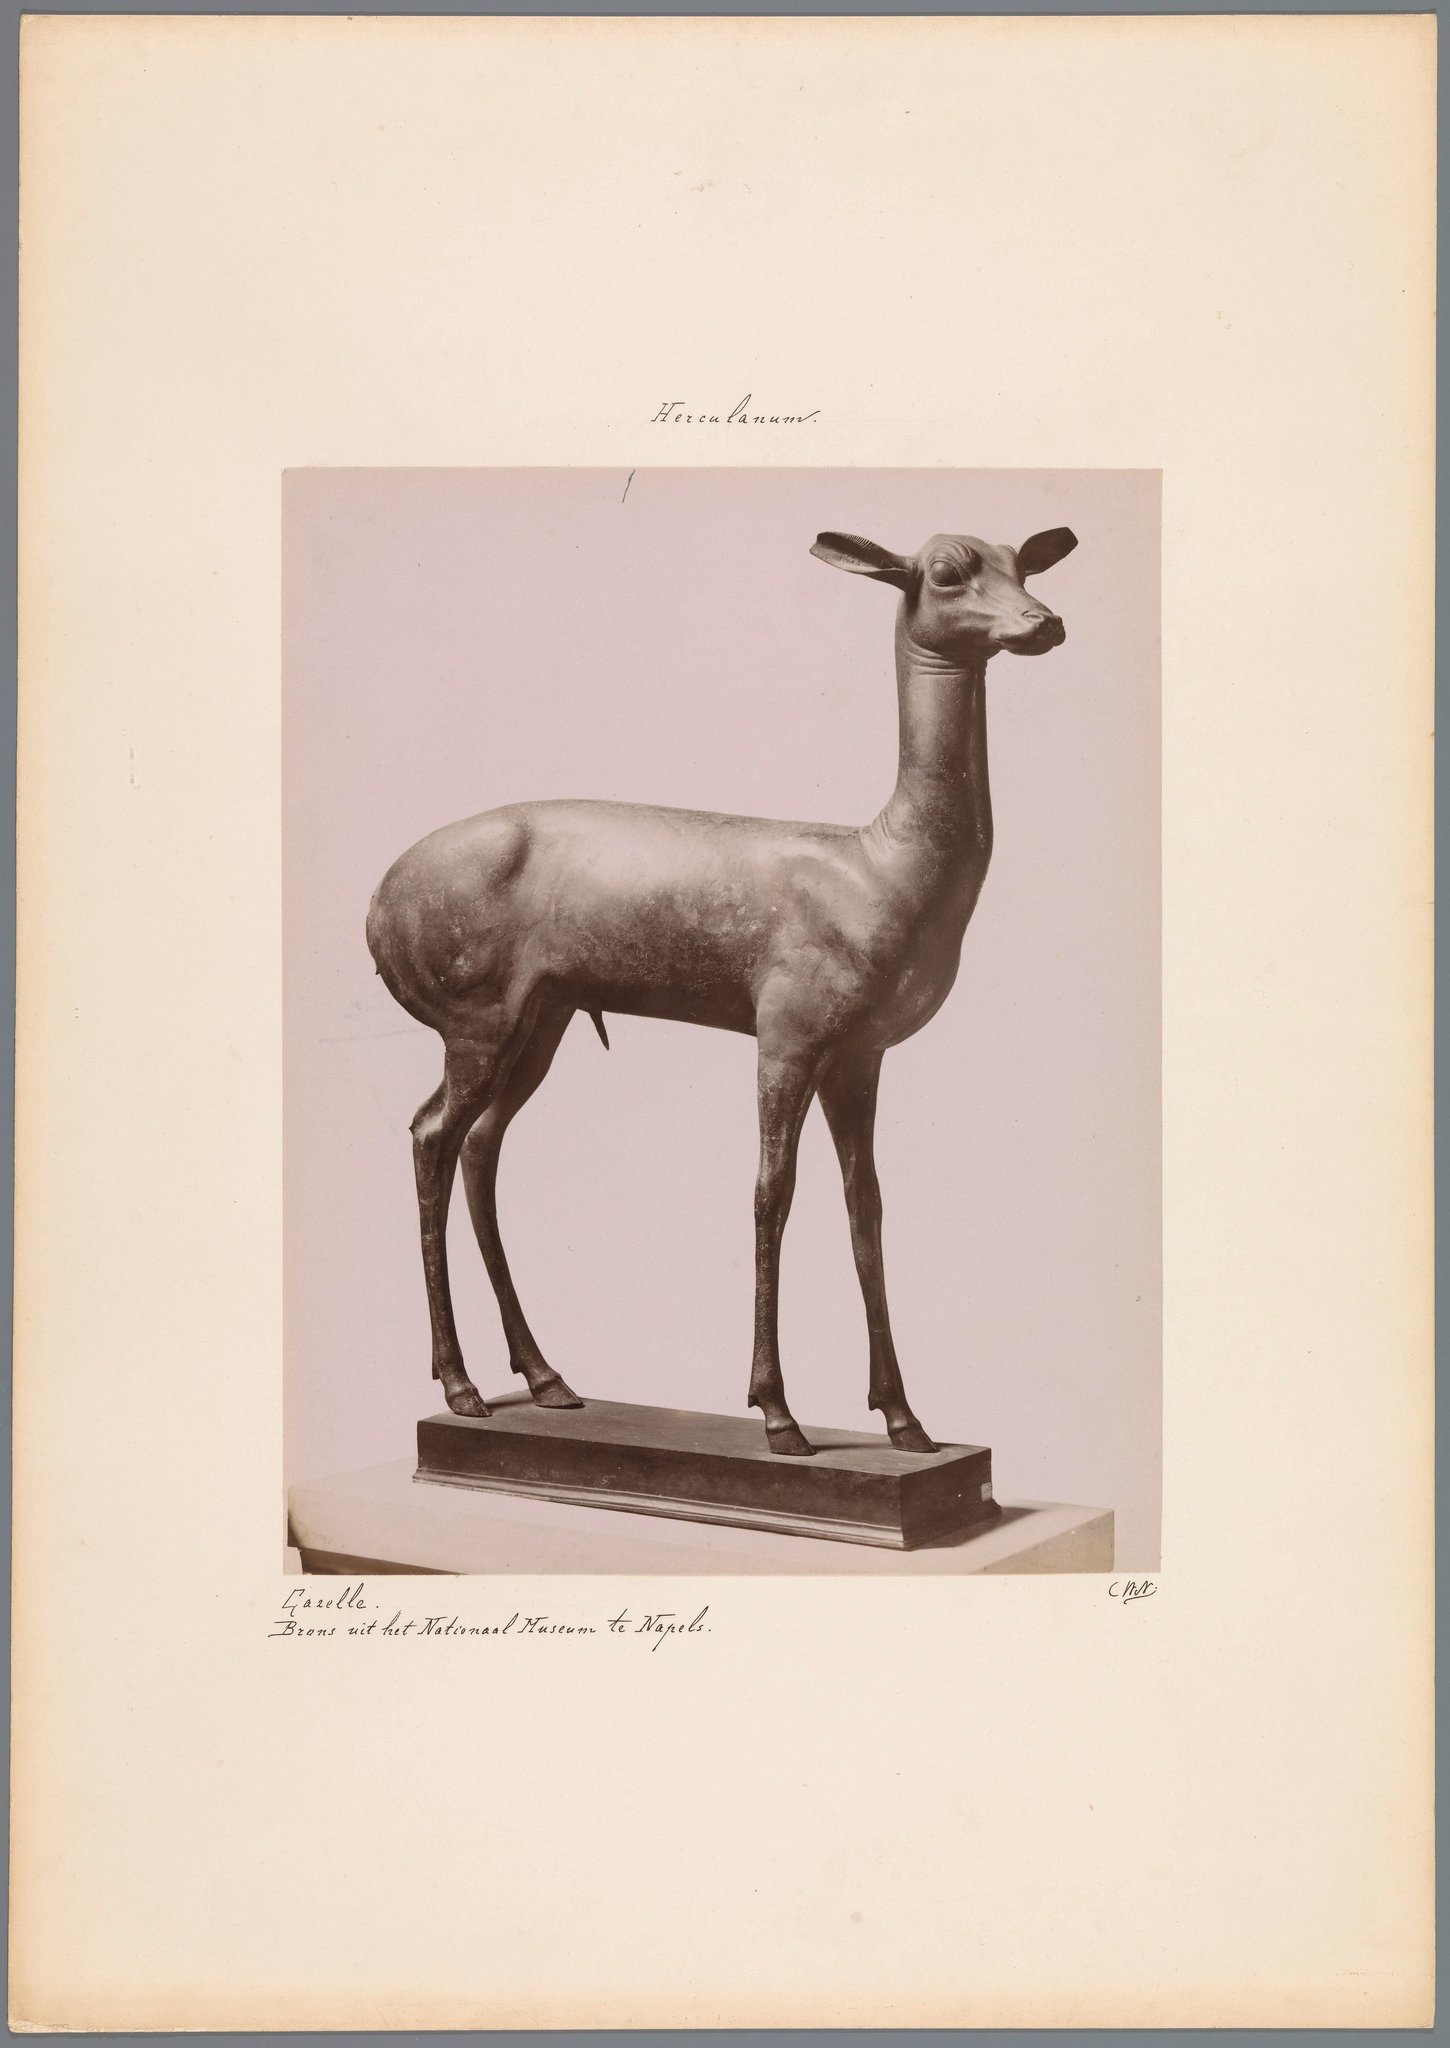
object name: photograph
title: Bronzen beeld van een reekalf, afkomstig uit Herculaneum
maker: Anonymous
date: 1875-1900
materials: cardboard, photographic support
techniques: albumen print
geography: naples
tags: hoofed animals: deer, sculpture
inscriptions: collector's mark: ‘INSTITUUT VOOR KUNST-NIJVERHEIDSONDERWIJS GABRIËL METSUSTRAAT No. 16. AMSTERDAM’, inscription: ‘CWN.’, inscription: ‘Herculanum. Gazelle. Brons uit het Nationaal Museum te Napels.’, collector's mark: ‘KUNSTNIJVERHEIDSCHOOL QUELLINUS AMSTERDAM FRANS HALSSTRAAT 14.’